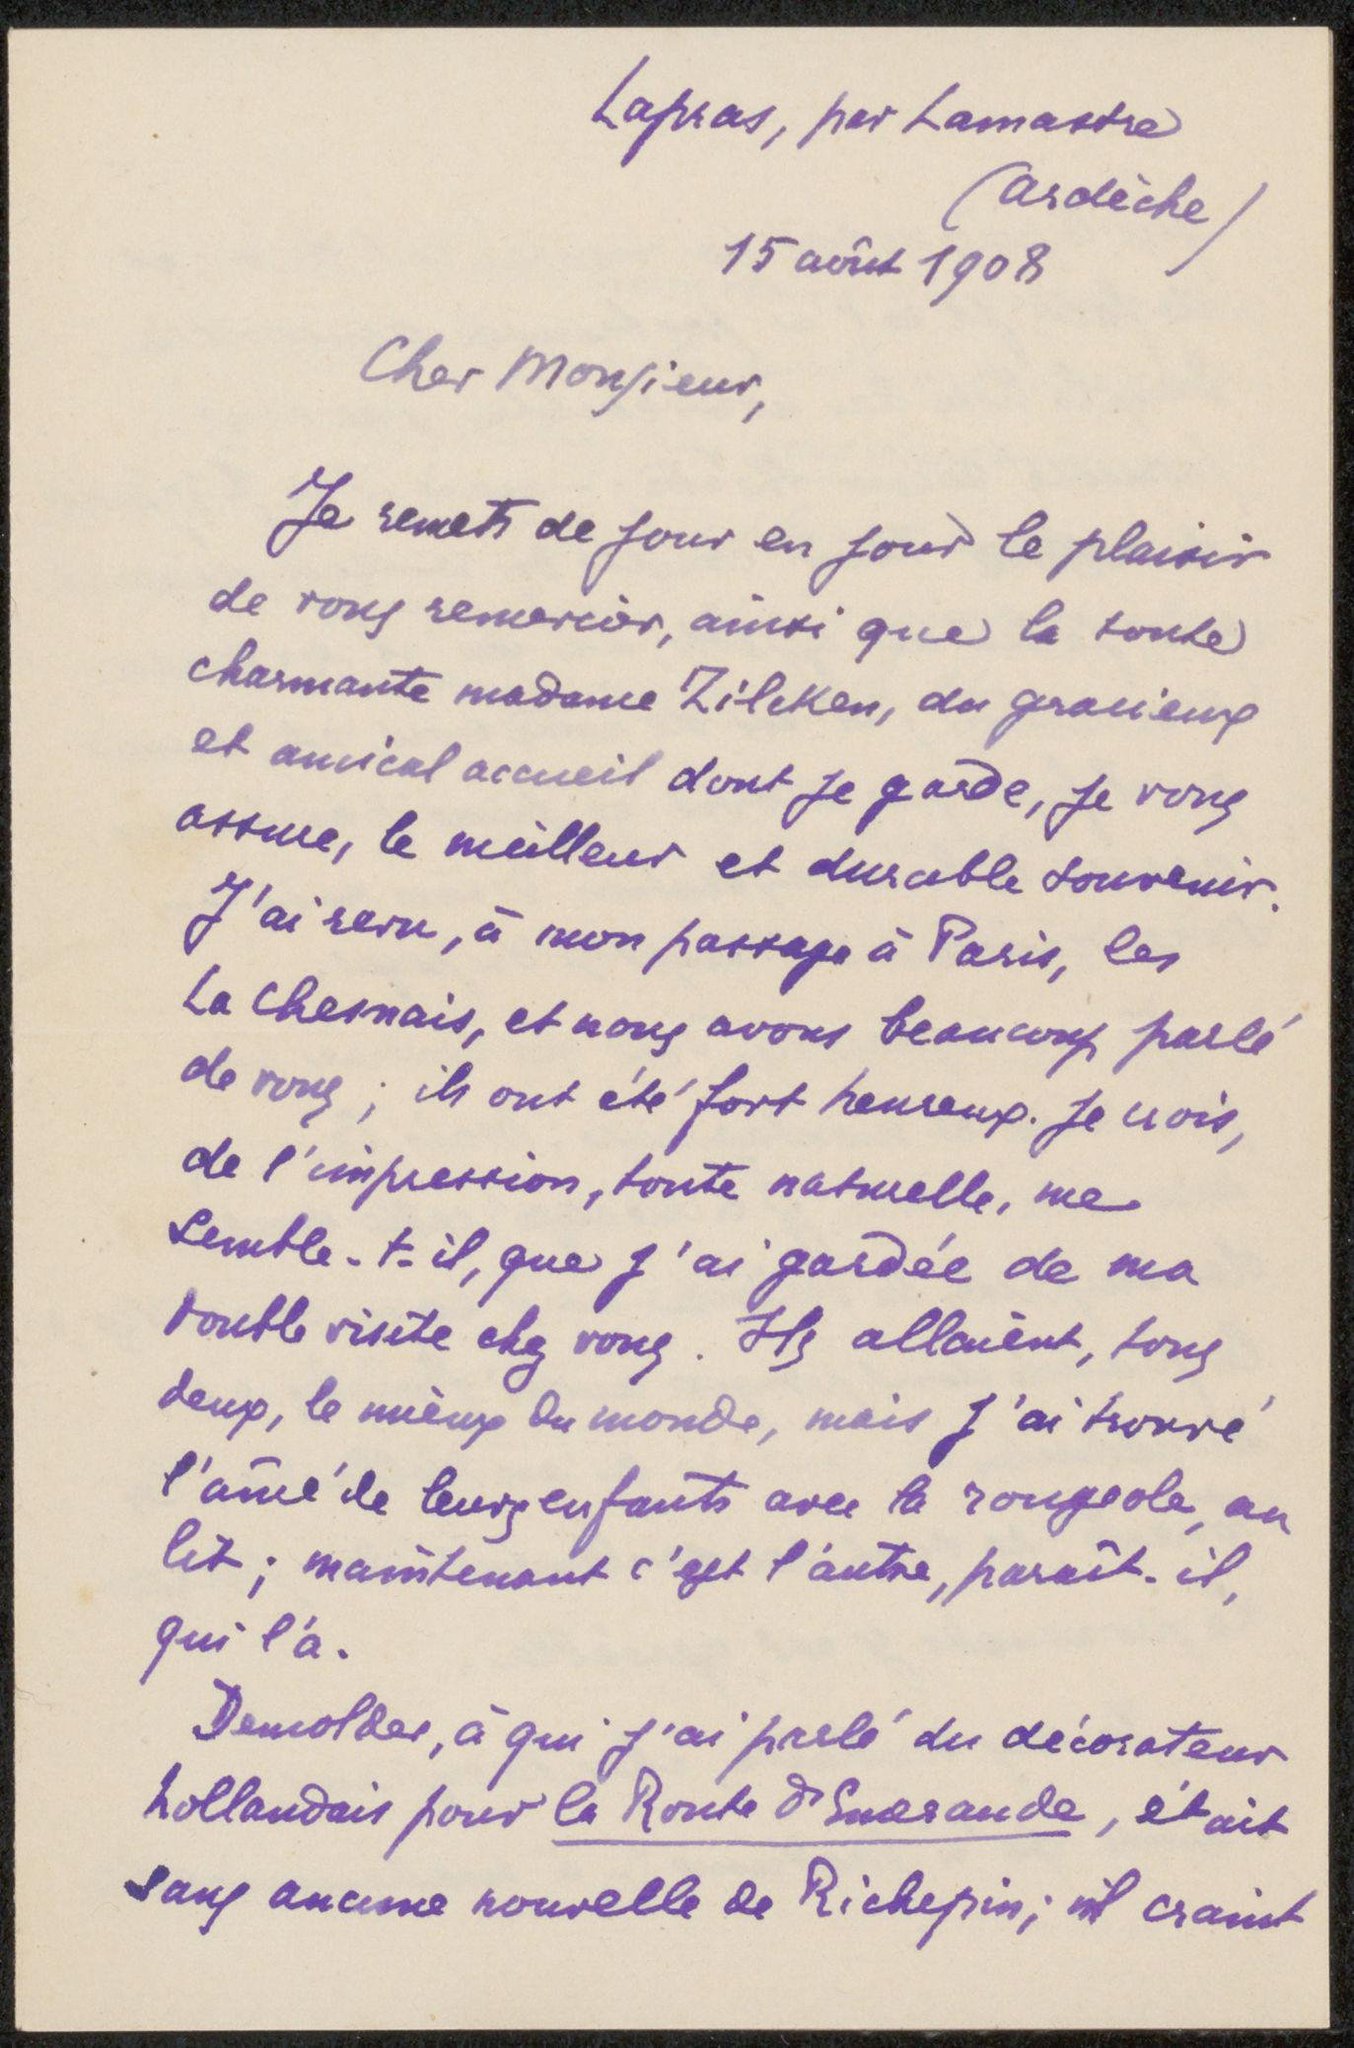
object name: letter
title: Brief aan Philip Zilcken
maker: andré fontainas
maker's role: criticus, dichter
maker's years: 1865-1948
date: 1908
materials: ink, paper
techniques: pen, writing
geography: lamastre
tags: the hague, painter, draughtsman, philip zilcken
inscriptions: watermark, collector's mark: ‘RPK’